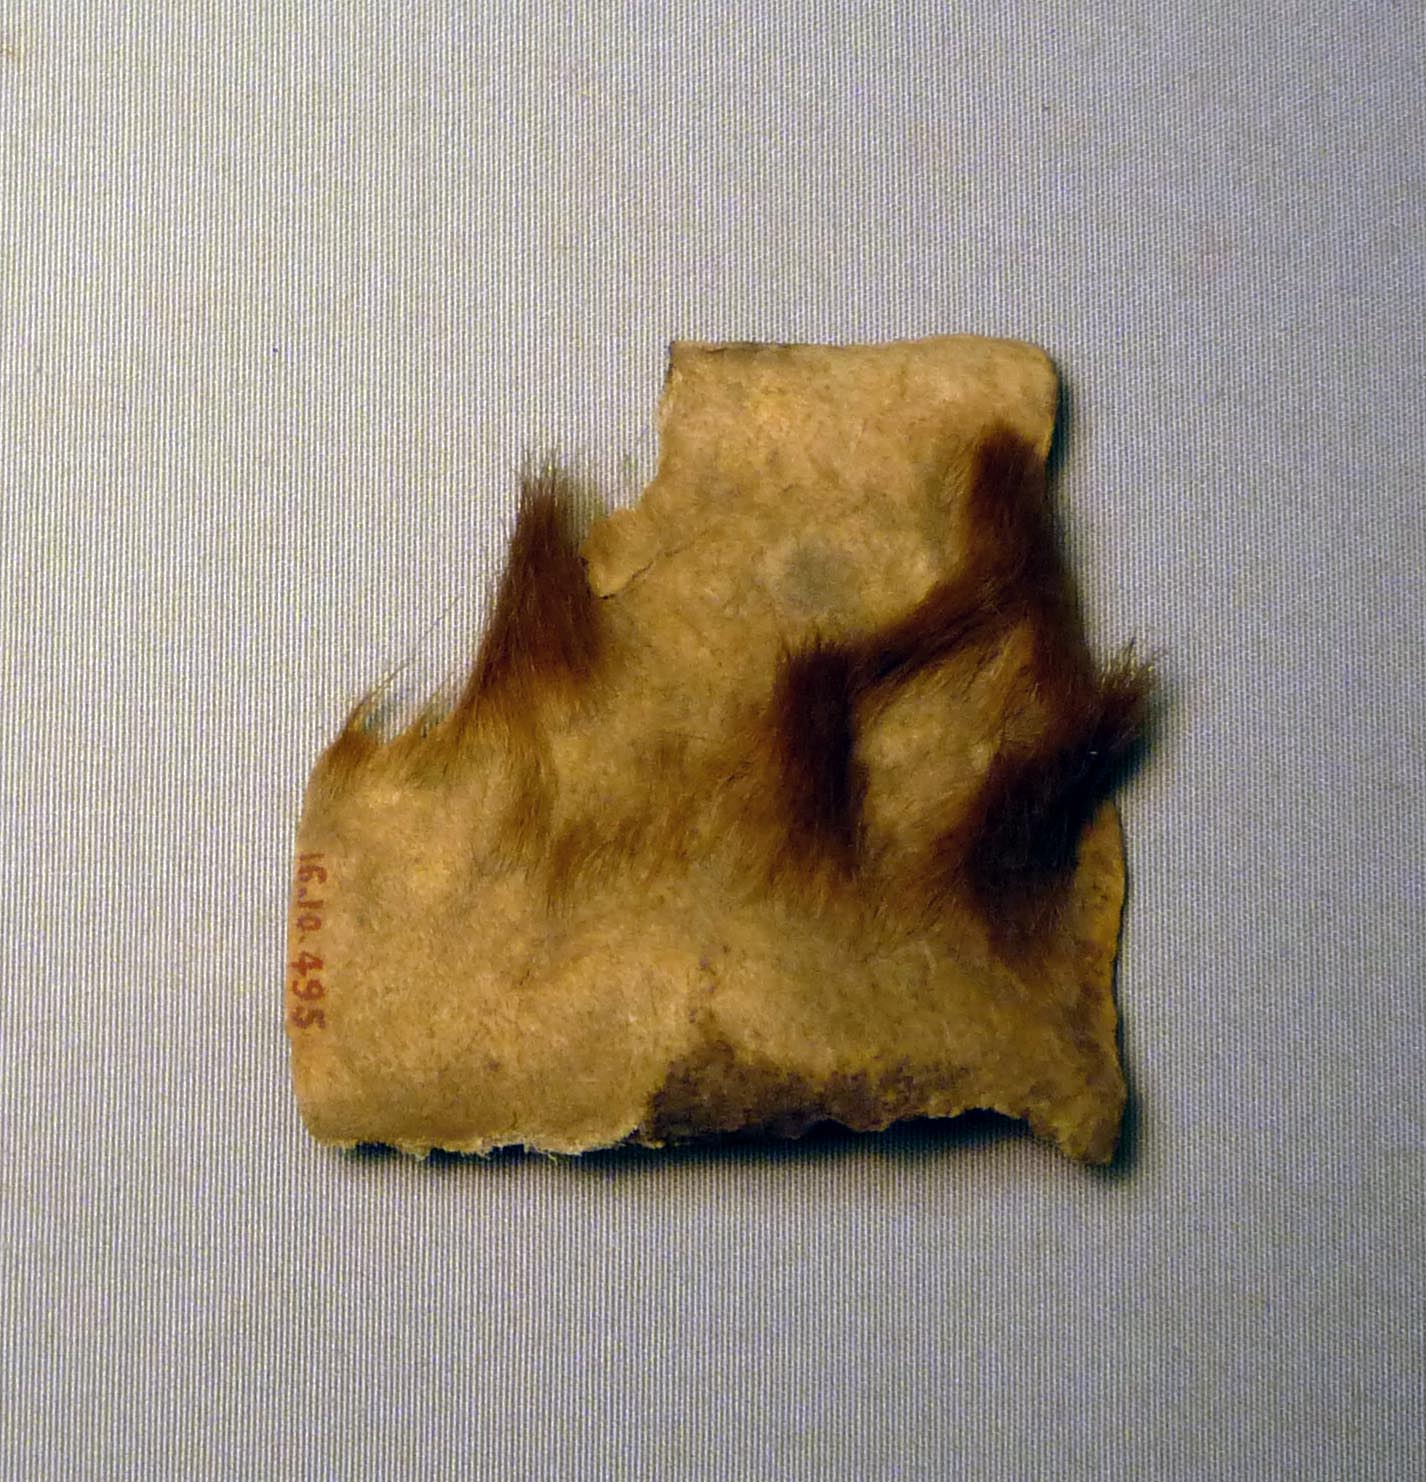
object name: leather fragment, foundation deposit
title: Hide Fragment From Foundation Deposit 2 of Hatshepsut's Valley Temple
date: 1479-1458 BCE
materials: leather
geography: egypt